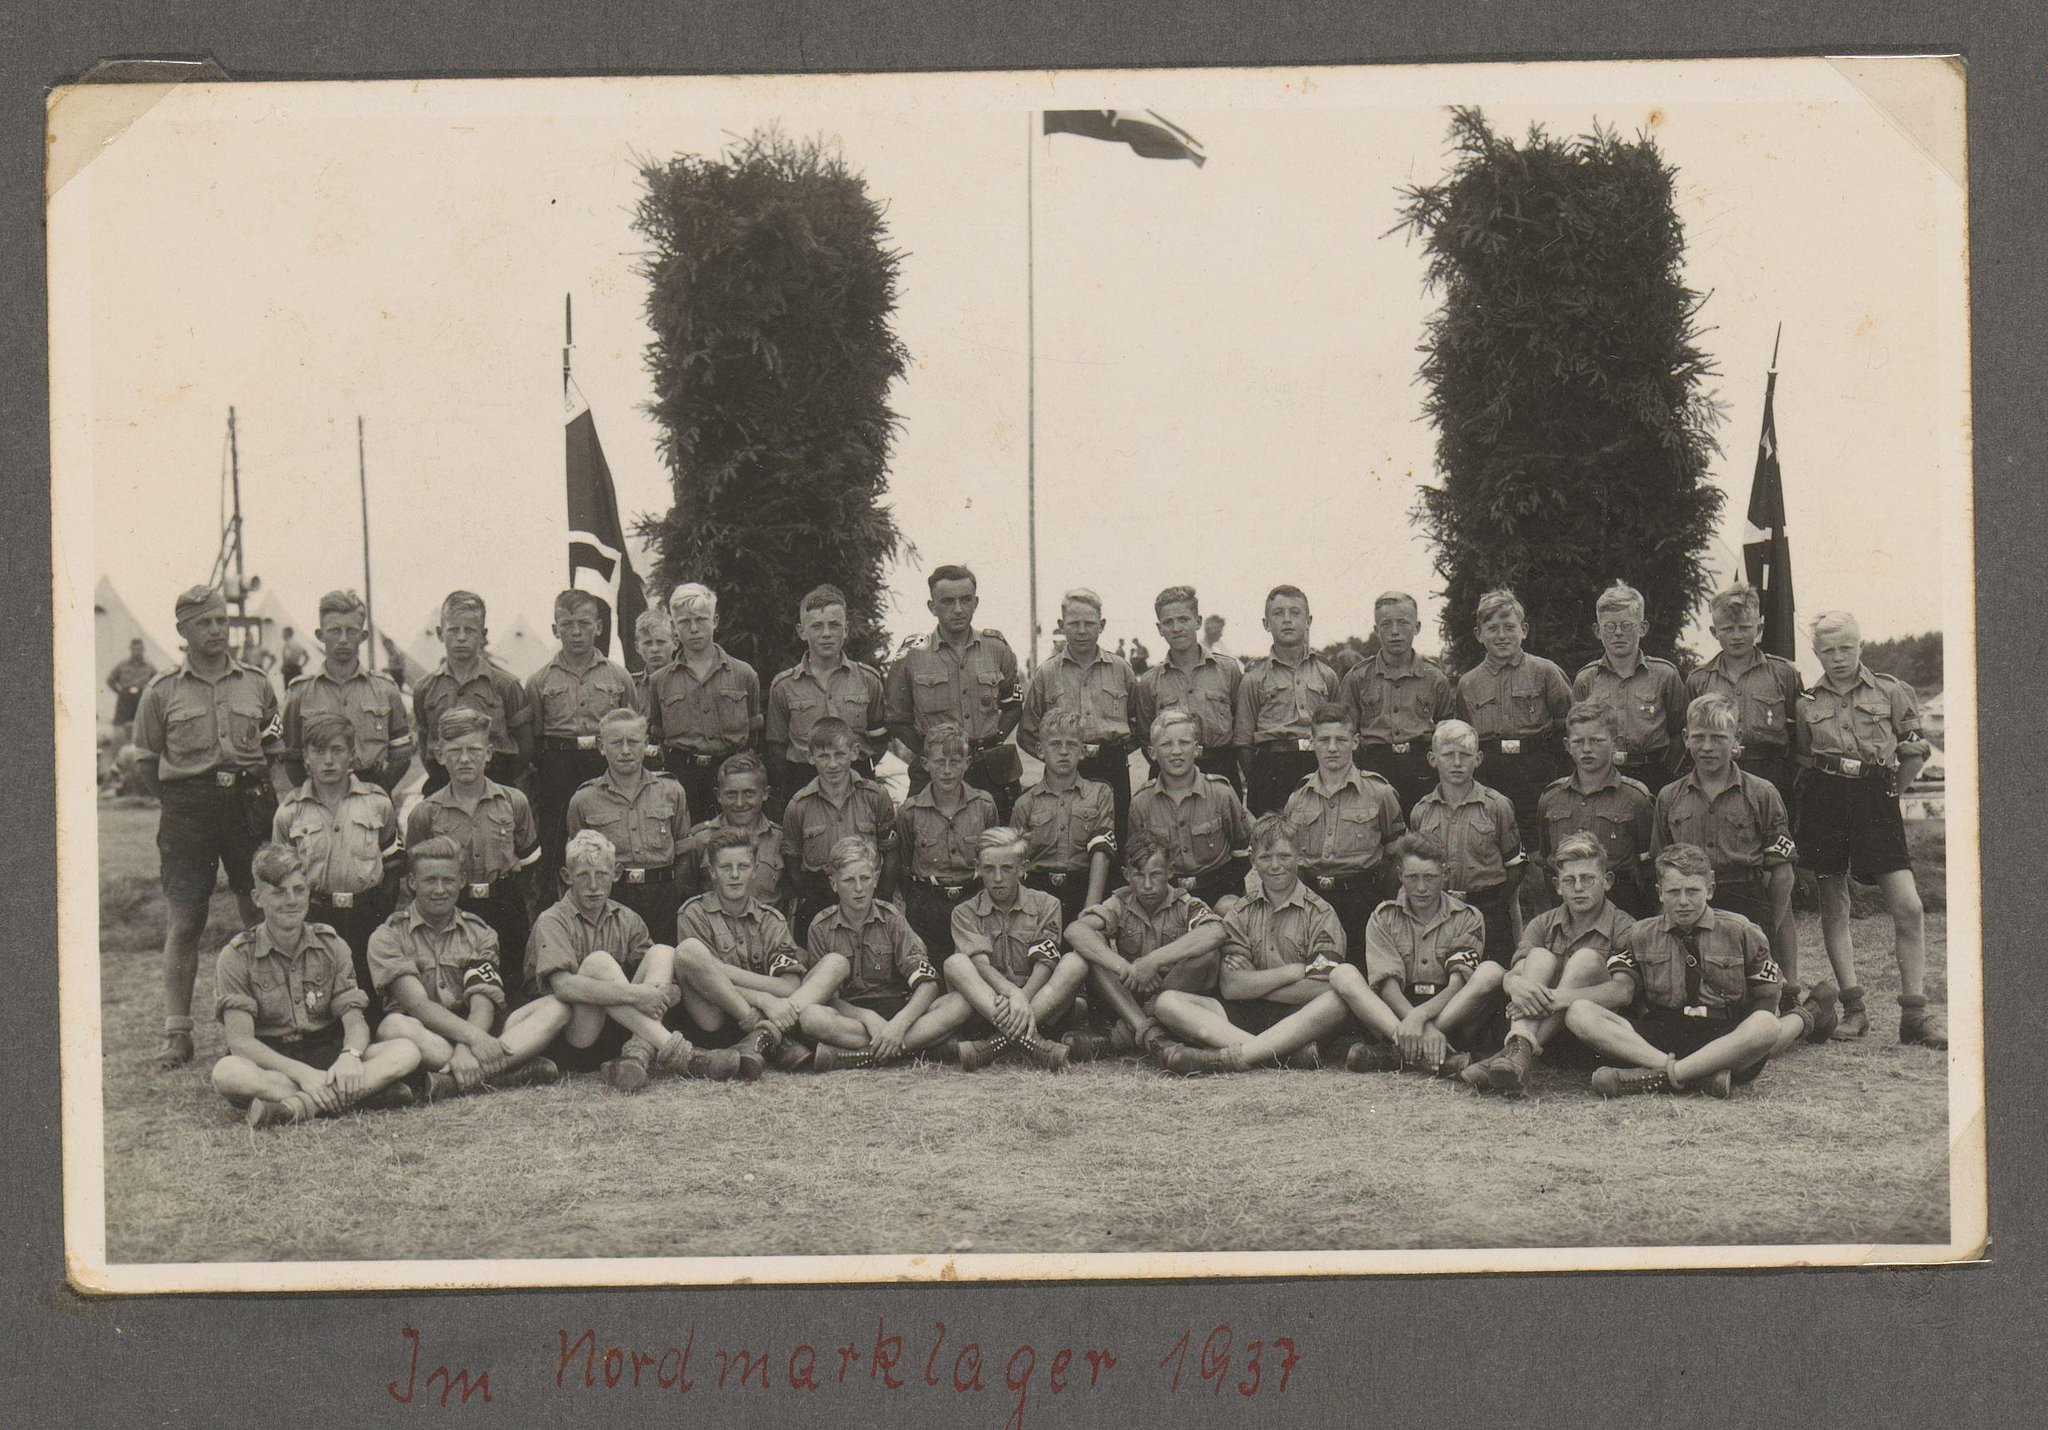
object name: album leaf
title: Groepsfoto tijdens een kamp van de Hitlerjeugd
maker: Anonymous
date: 1937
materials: paper, photographic support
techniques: gelatin silver print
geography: netherlands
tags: youth, adolescent, anonymous historical persons portrayed in a group, in a group-portrait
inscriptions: inscription: ‘Im Nordmarklager 1937’